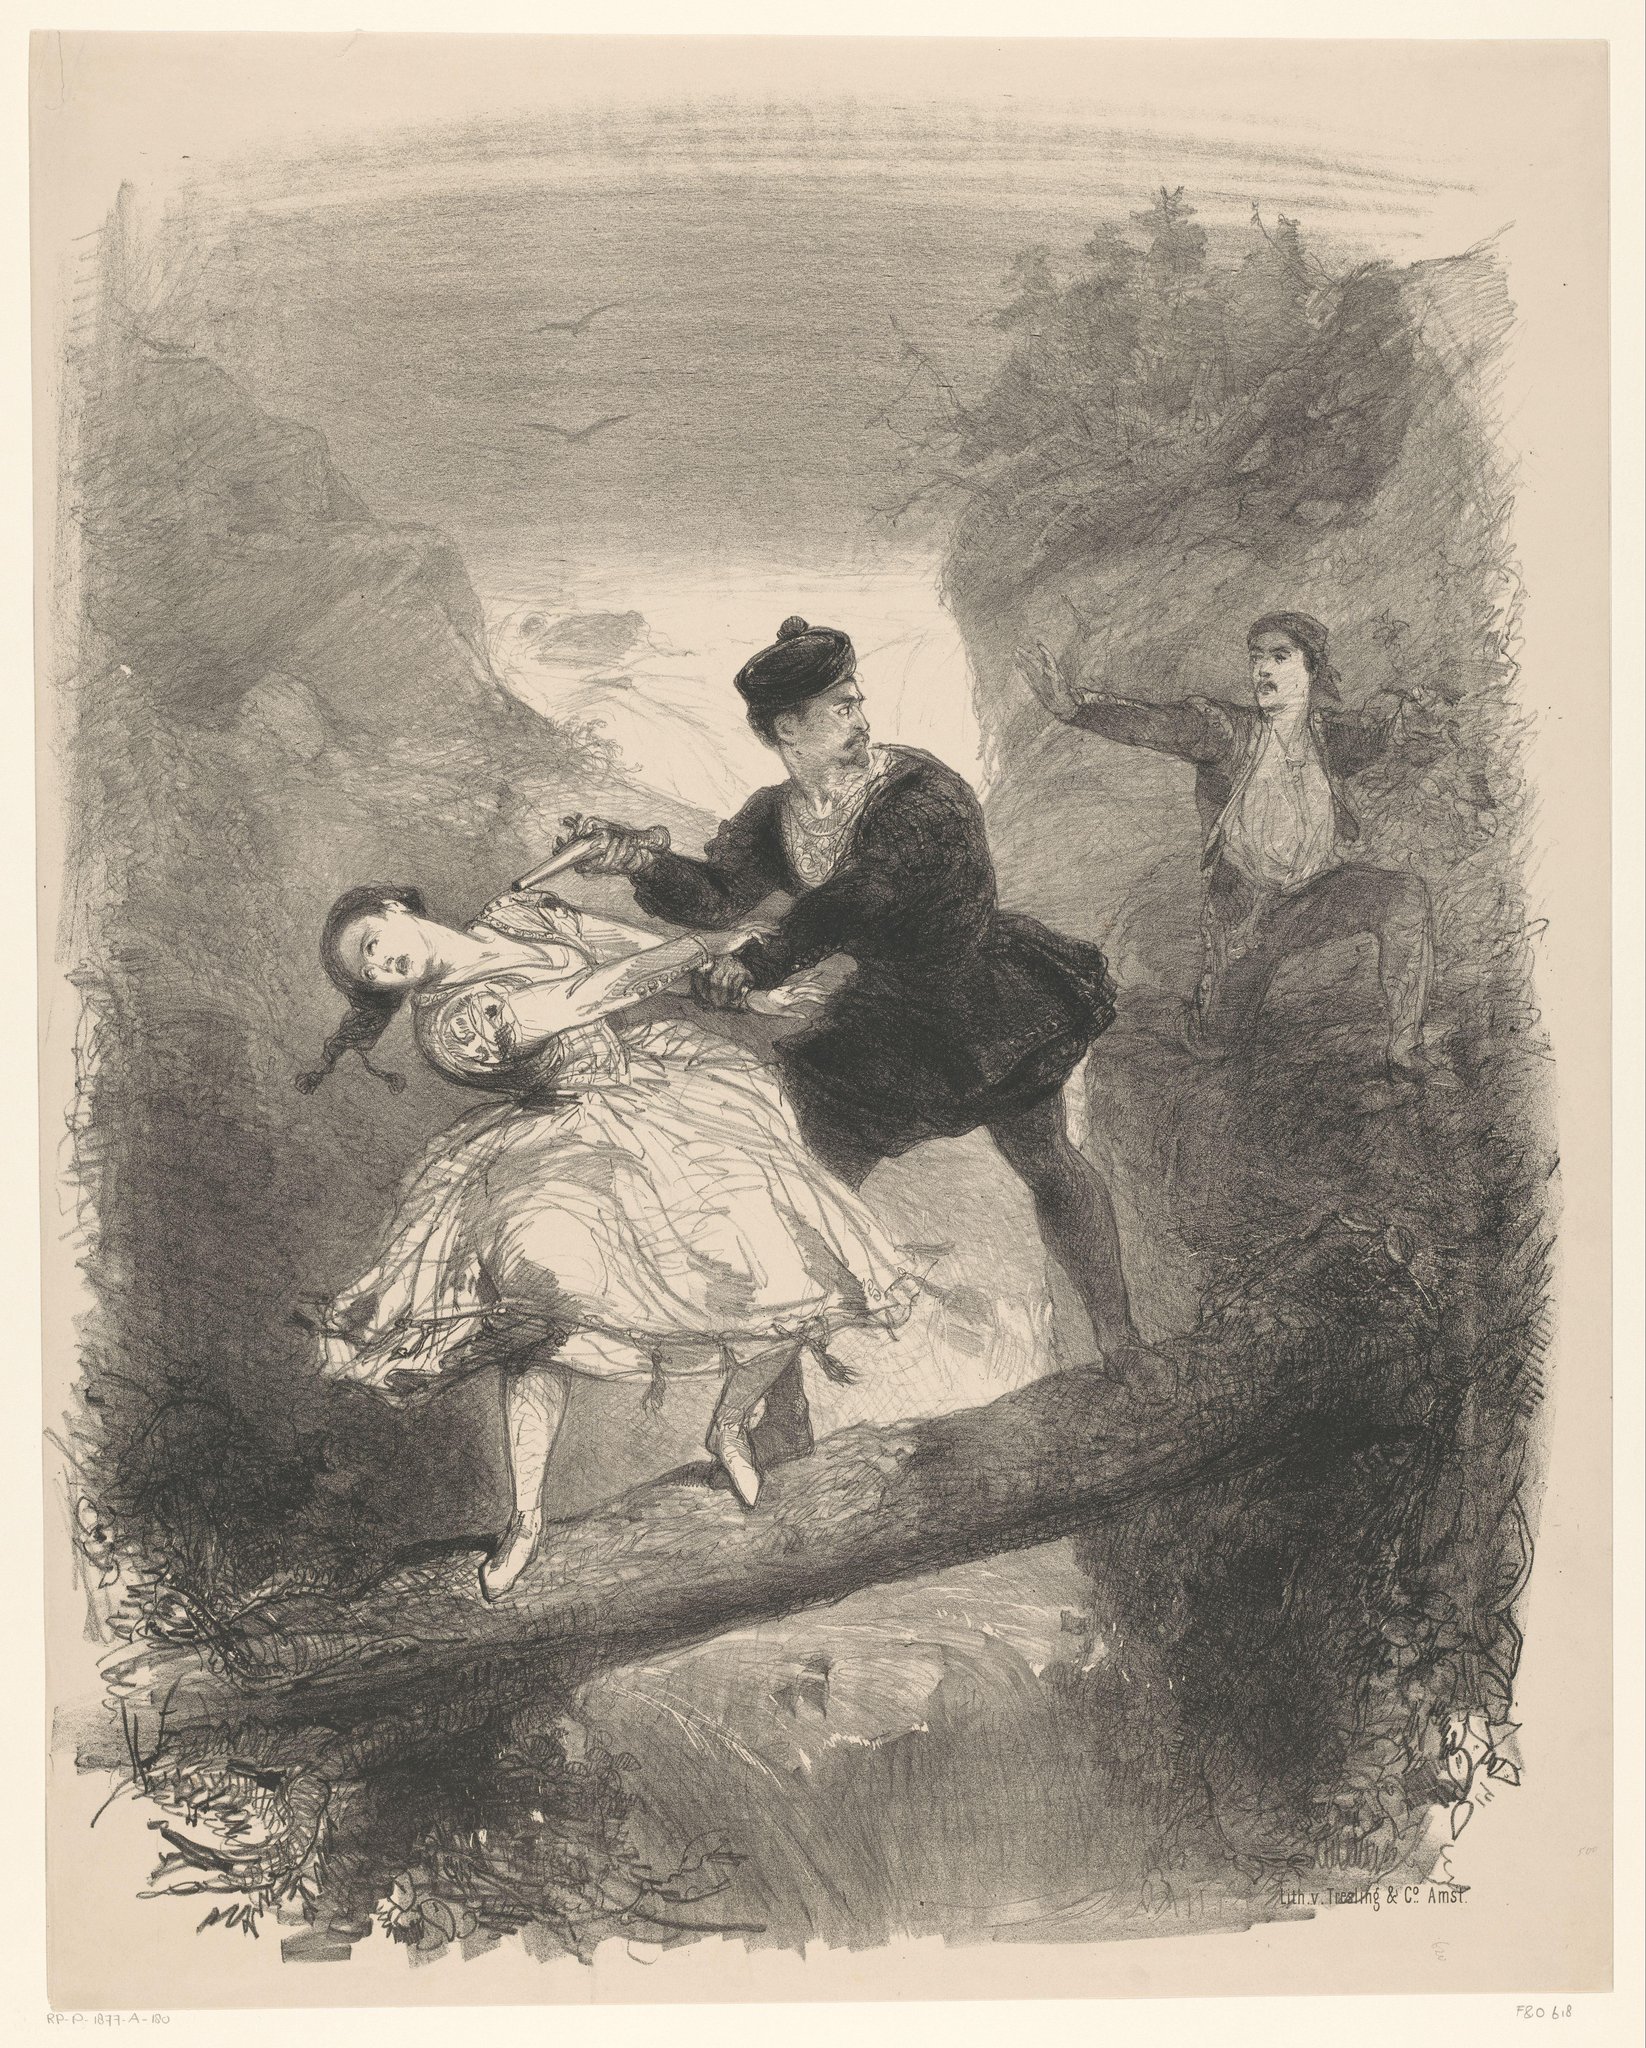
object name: print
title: Balletscène met man en vrouw boven afgrond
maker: charles rochussen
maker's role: draughtsman, painter, print maker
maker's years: 1814-1894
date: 1865-1868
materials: paper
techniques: lithograph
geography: amsterdam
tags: the ballet, ballet performance, ravine, chasm, abyss, canyon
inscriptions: collector's mark: Lugt 2228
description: Een man en jonge vrouw steken een afgrond over via een boomstam. De man houdt zijn pistool op de borst van de vrouw. Een jonge man achtervolgt hen.